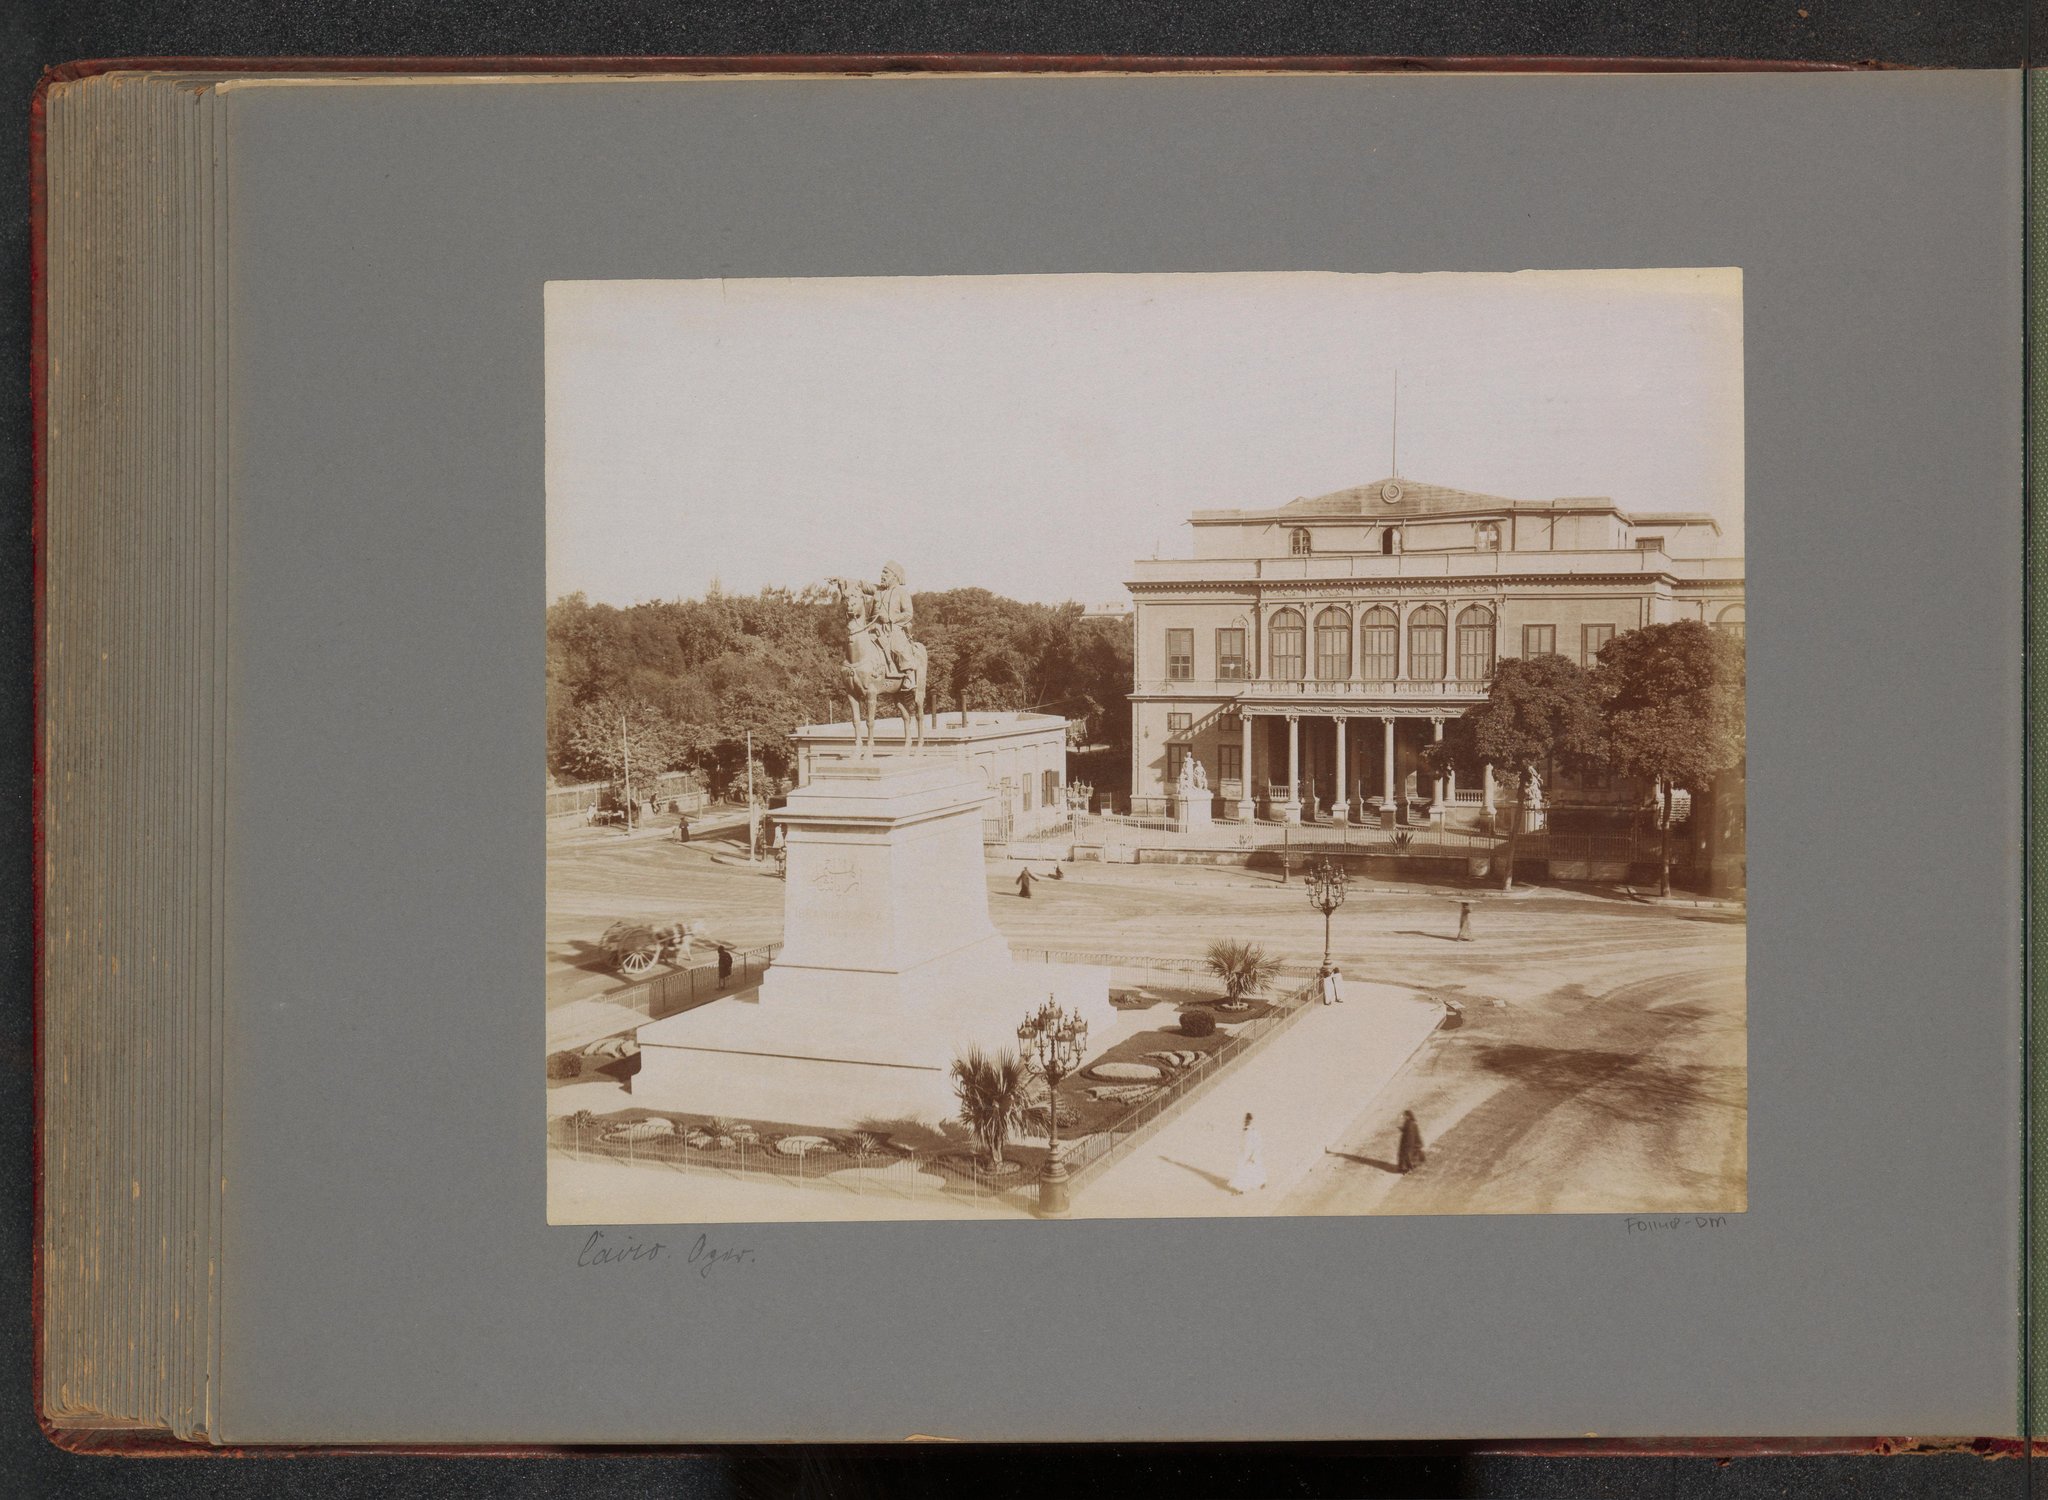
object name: photograph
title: Plein in Caïro met het ruiterstandbeeld van Ibrahim Pasja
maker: Anonymous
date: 1895-1905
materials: paper, photographic support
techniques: albumen print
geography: cairo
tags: equestrian statue, square, place, circus, etc. (+ city(-scape) with figures, staffage)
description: Onderdeel van Reisalbum met foto's van bezienswaardigheden in Griekenland en Egypte.